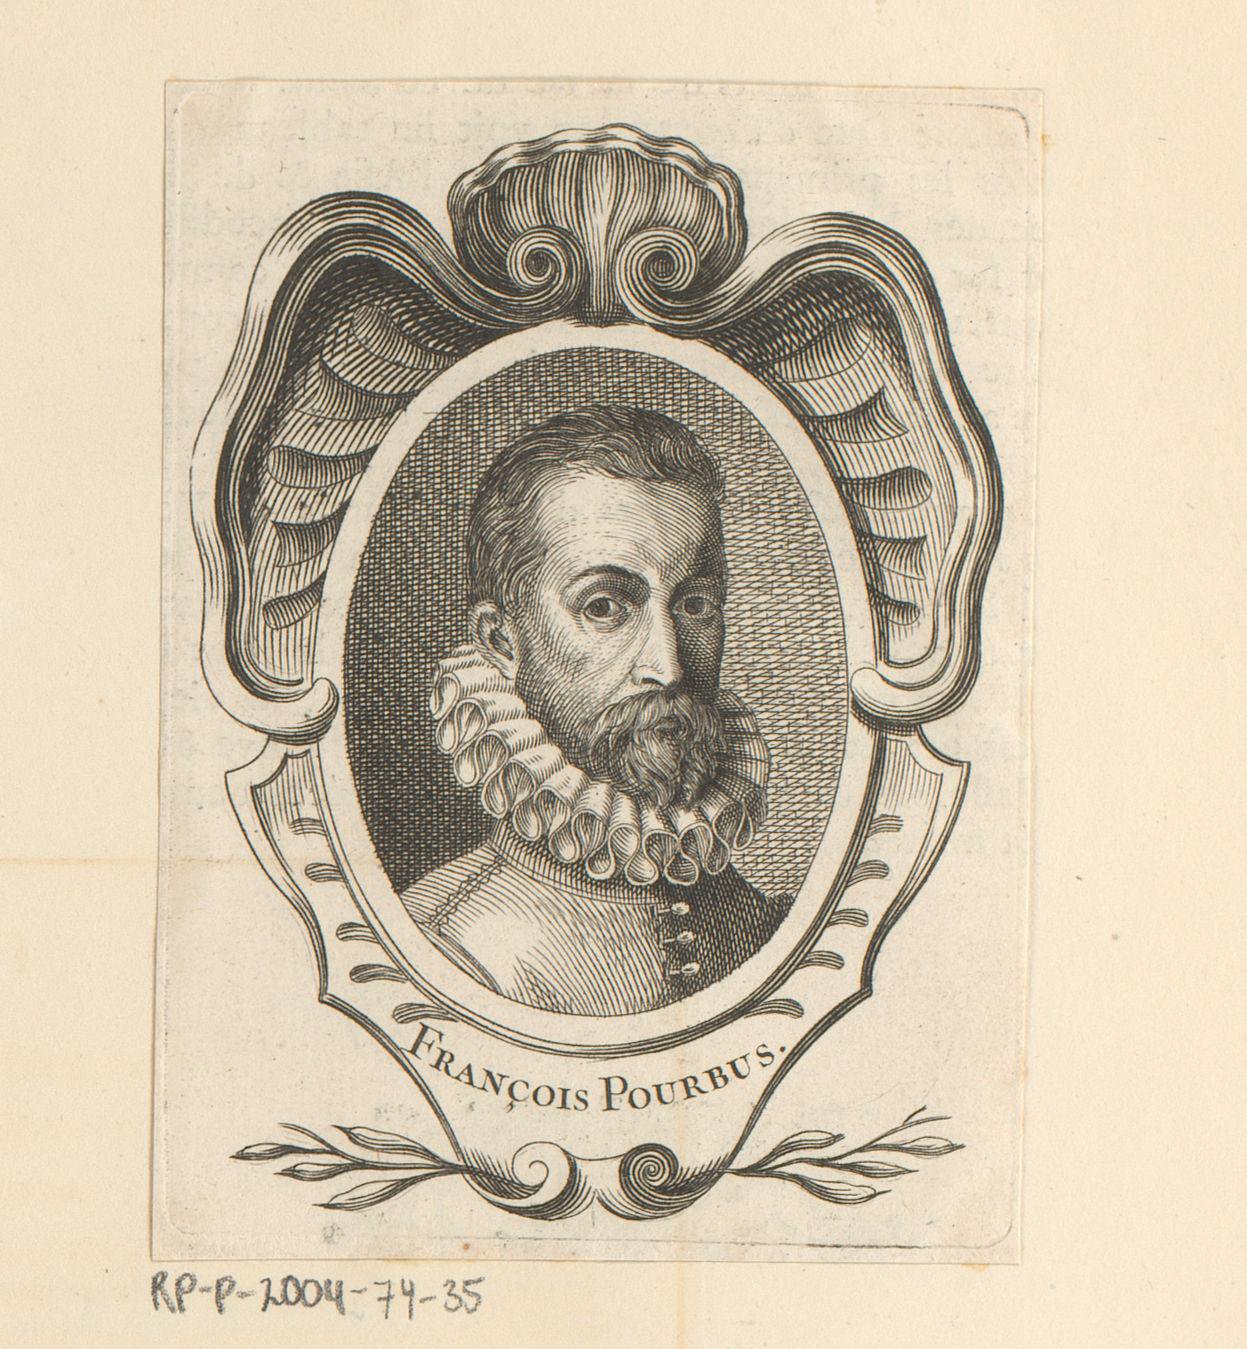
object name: print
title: François Pourbus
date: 1745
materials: paper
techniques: engraving, letterpress printing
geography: paris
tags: antwerp, painter, frans pourbus (i), historical persons, portrait, self-portrait of painter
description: Prent uit: Dézallier d'Argenville, Antoine Joseph. Abrégé de la vie des plus fameux peintres. 4 dln. Parijs: De Bure l'aîné, 1745, dl. 2, p.118. De samensteller heeft deze prent in het album geplakt als illustratie bij: Pilkington, Matthew en Johann Heinrich Füssli. A dictionary of painters, from the revival of the art to the present period. 4 dln. Londen: John Crowder, 1805, dl. 3, p. 411.